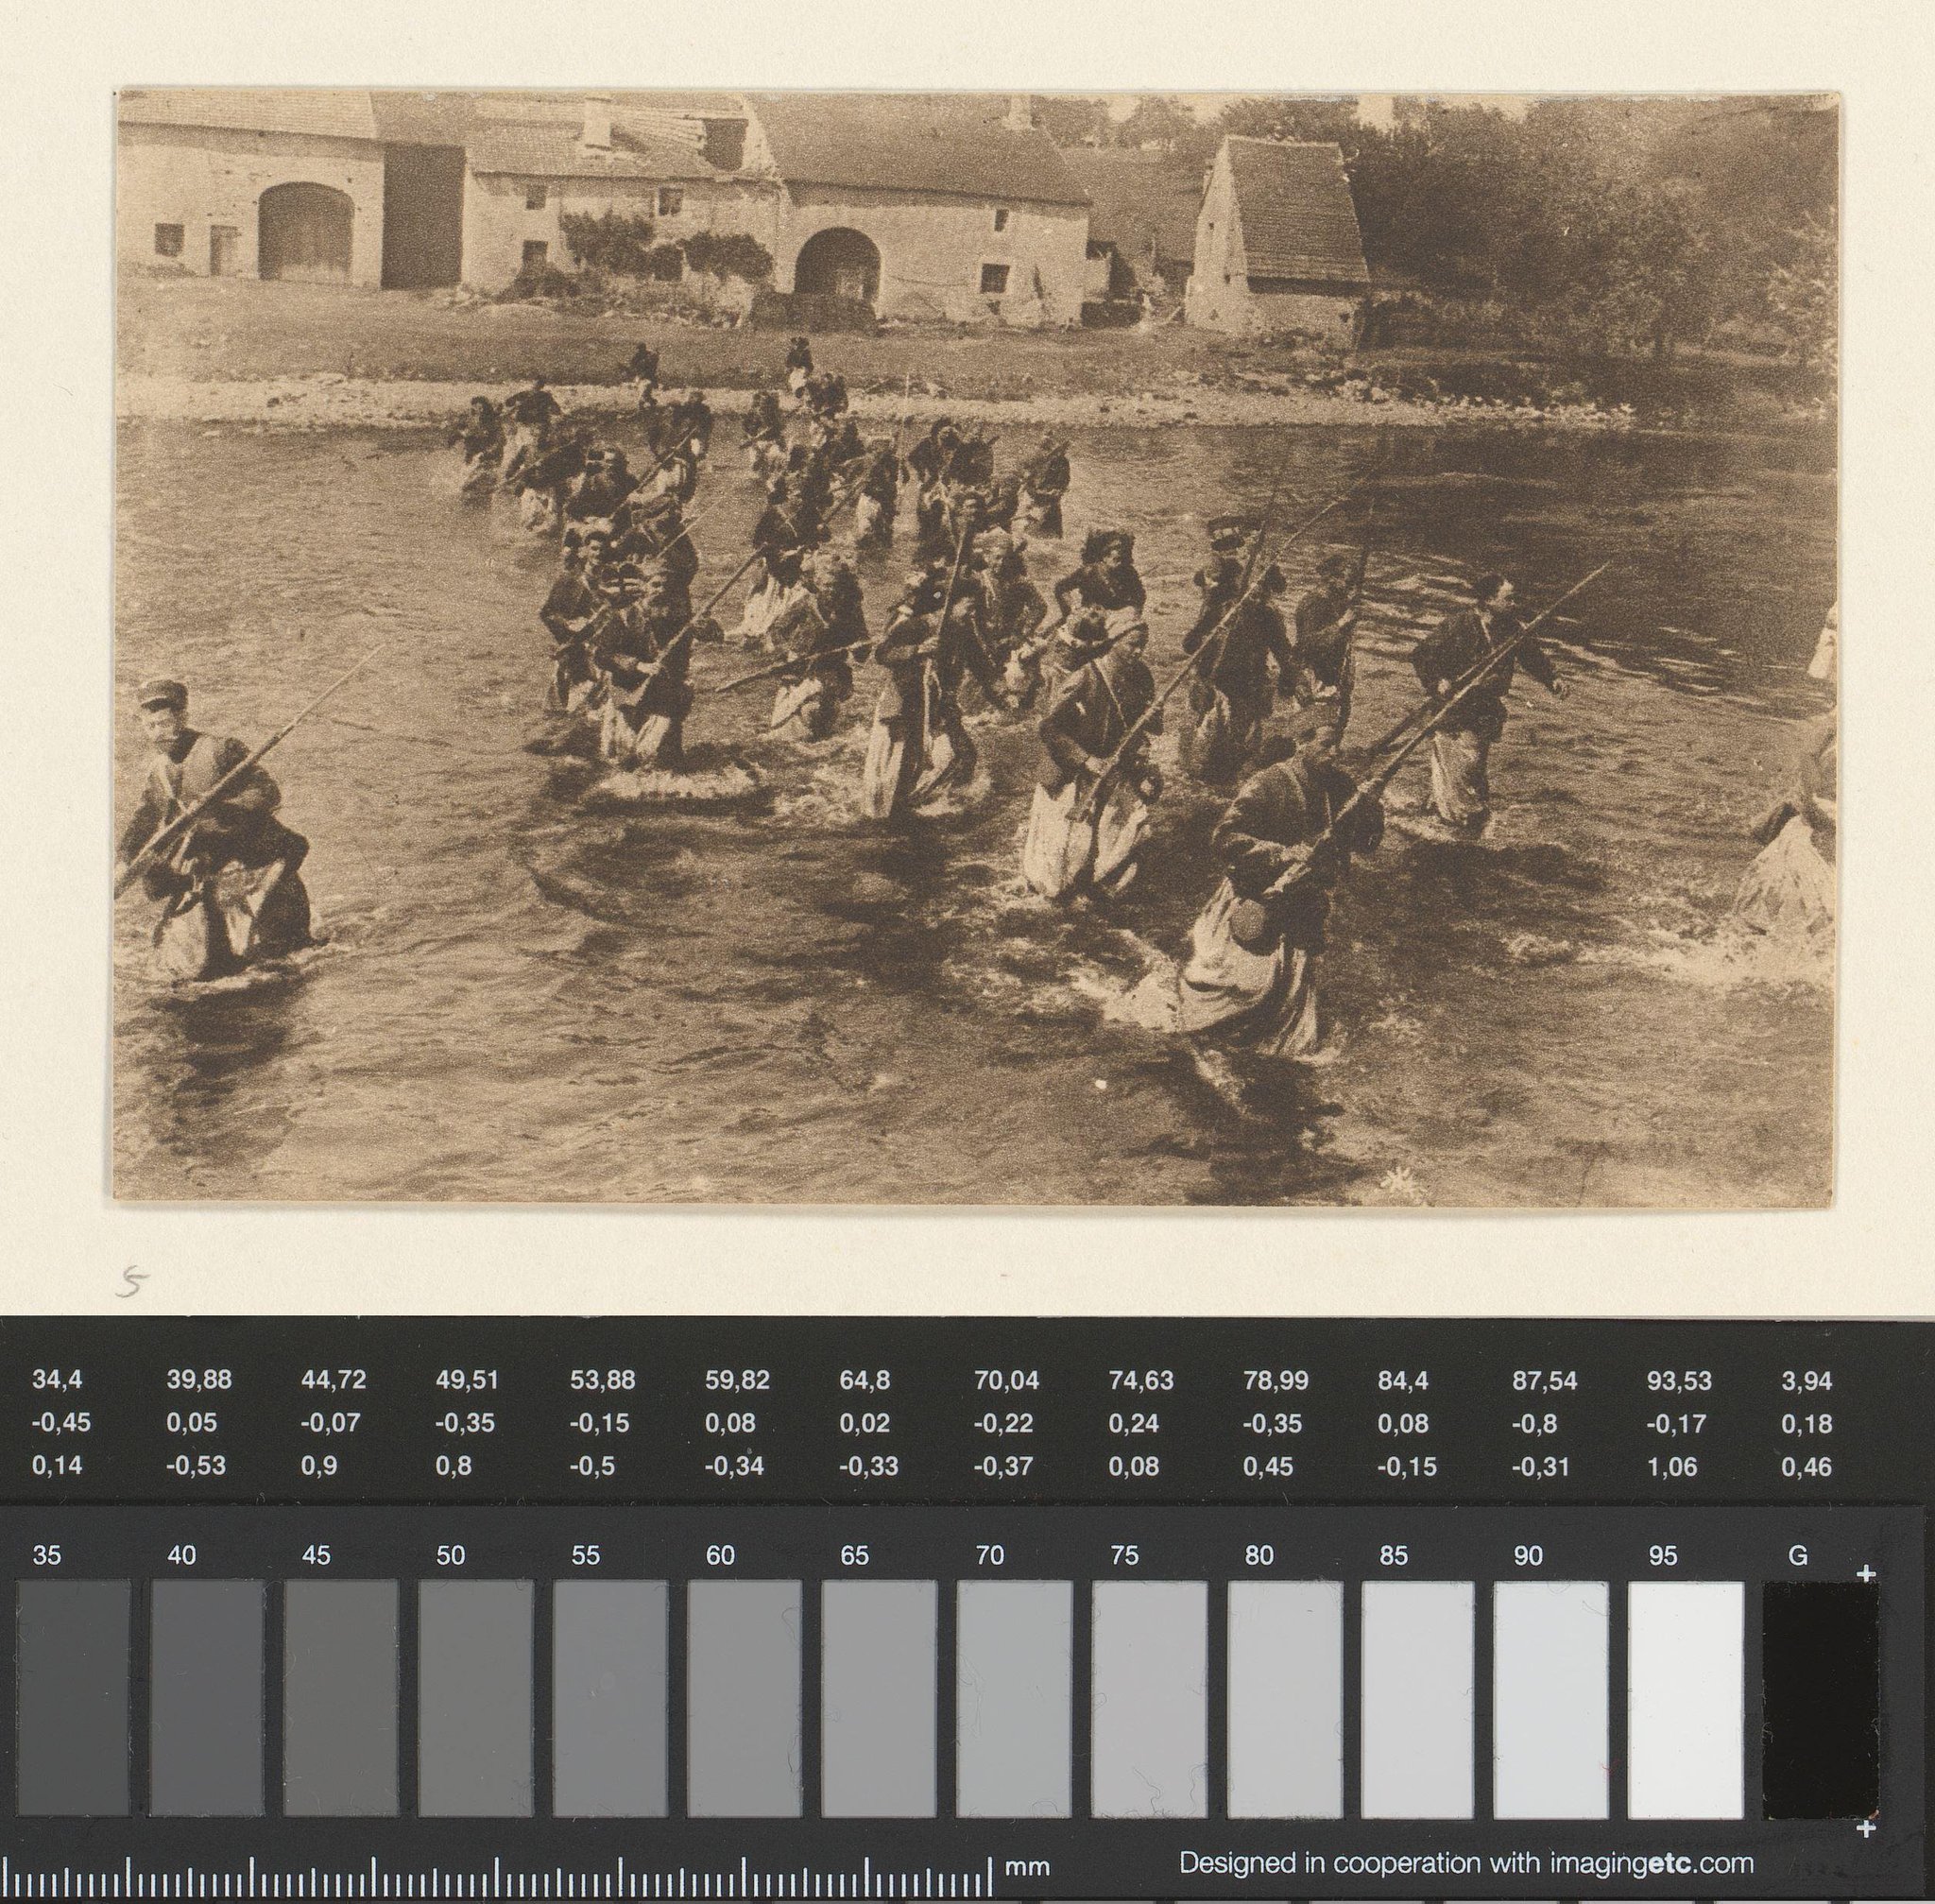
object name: ansichtkaart, prentbriefkaart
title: 12 cartes postales illustrées de la Grande Guerre / Pochette No 1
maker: sémaphore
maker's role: printer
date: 1914-1915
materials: paper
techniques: photograph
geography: marseille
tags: troop movements, transportation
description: Algerijnse tirailleurs steken een rivier over. Onderdeel van de eerste serie van twaalf (elf aanwezig) prentbriefkaarten over de Eerste Wereldoorlog, 1914-1915.